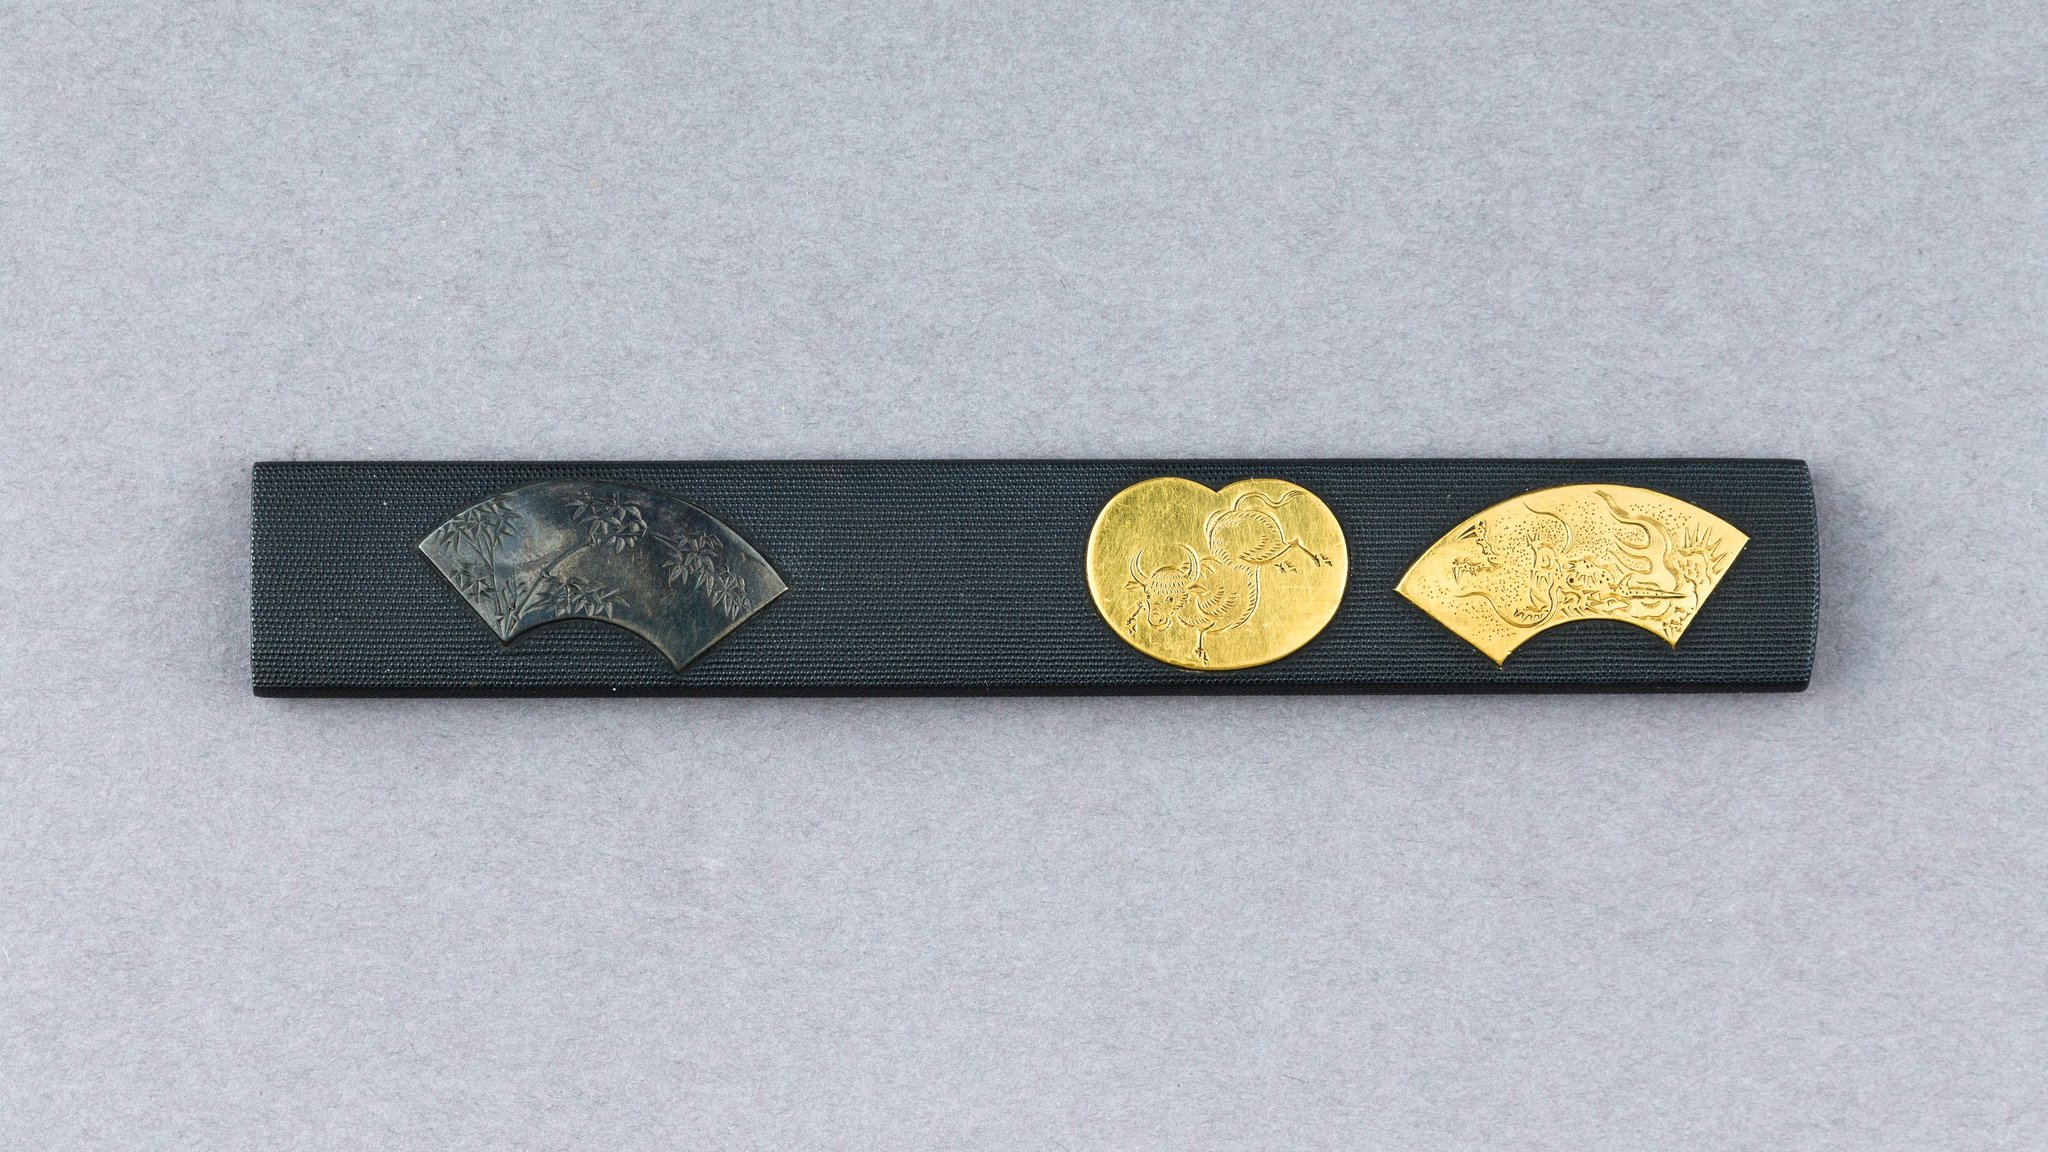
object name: knife handle kozuka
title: Knife Handle (Kozuka)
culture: japanese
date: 1615-1868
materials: gold alloy, gold, silver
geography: japan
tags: fans